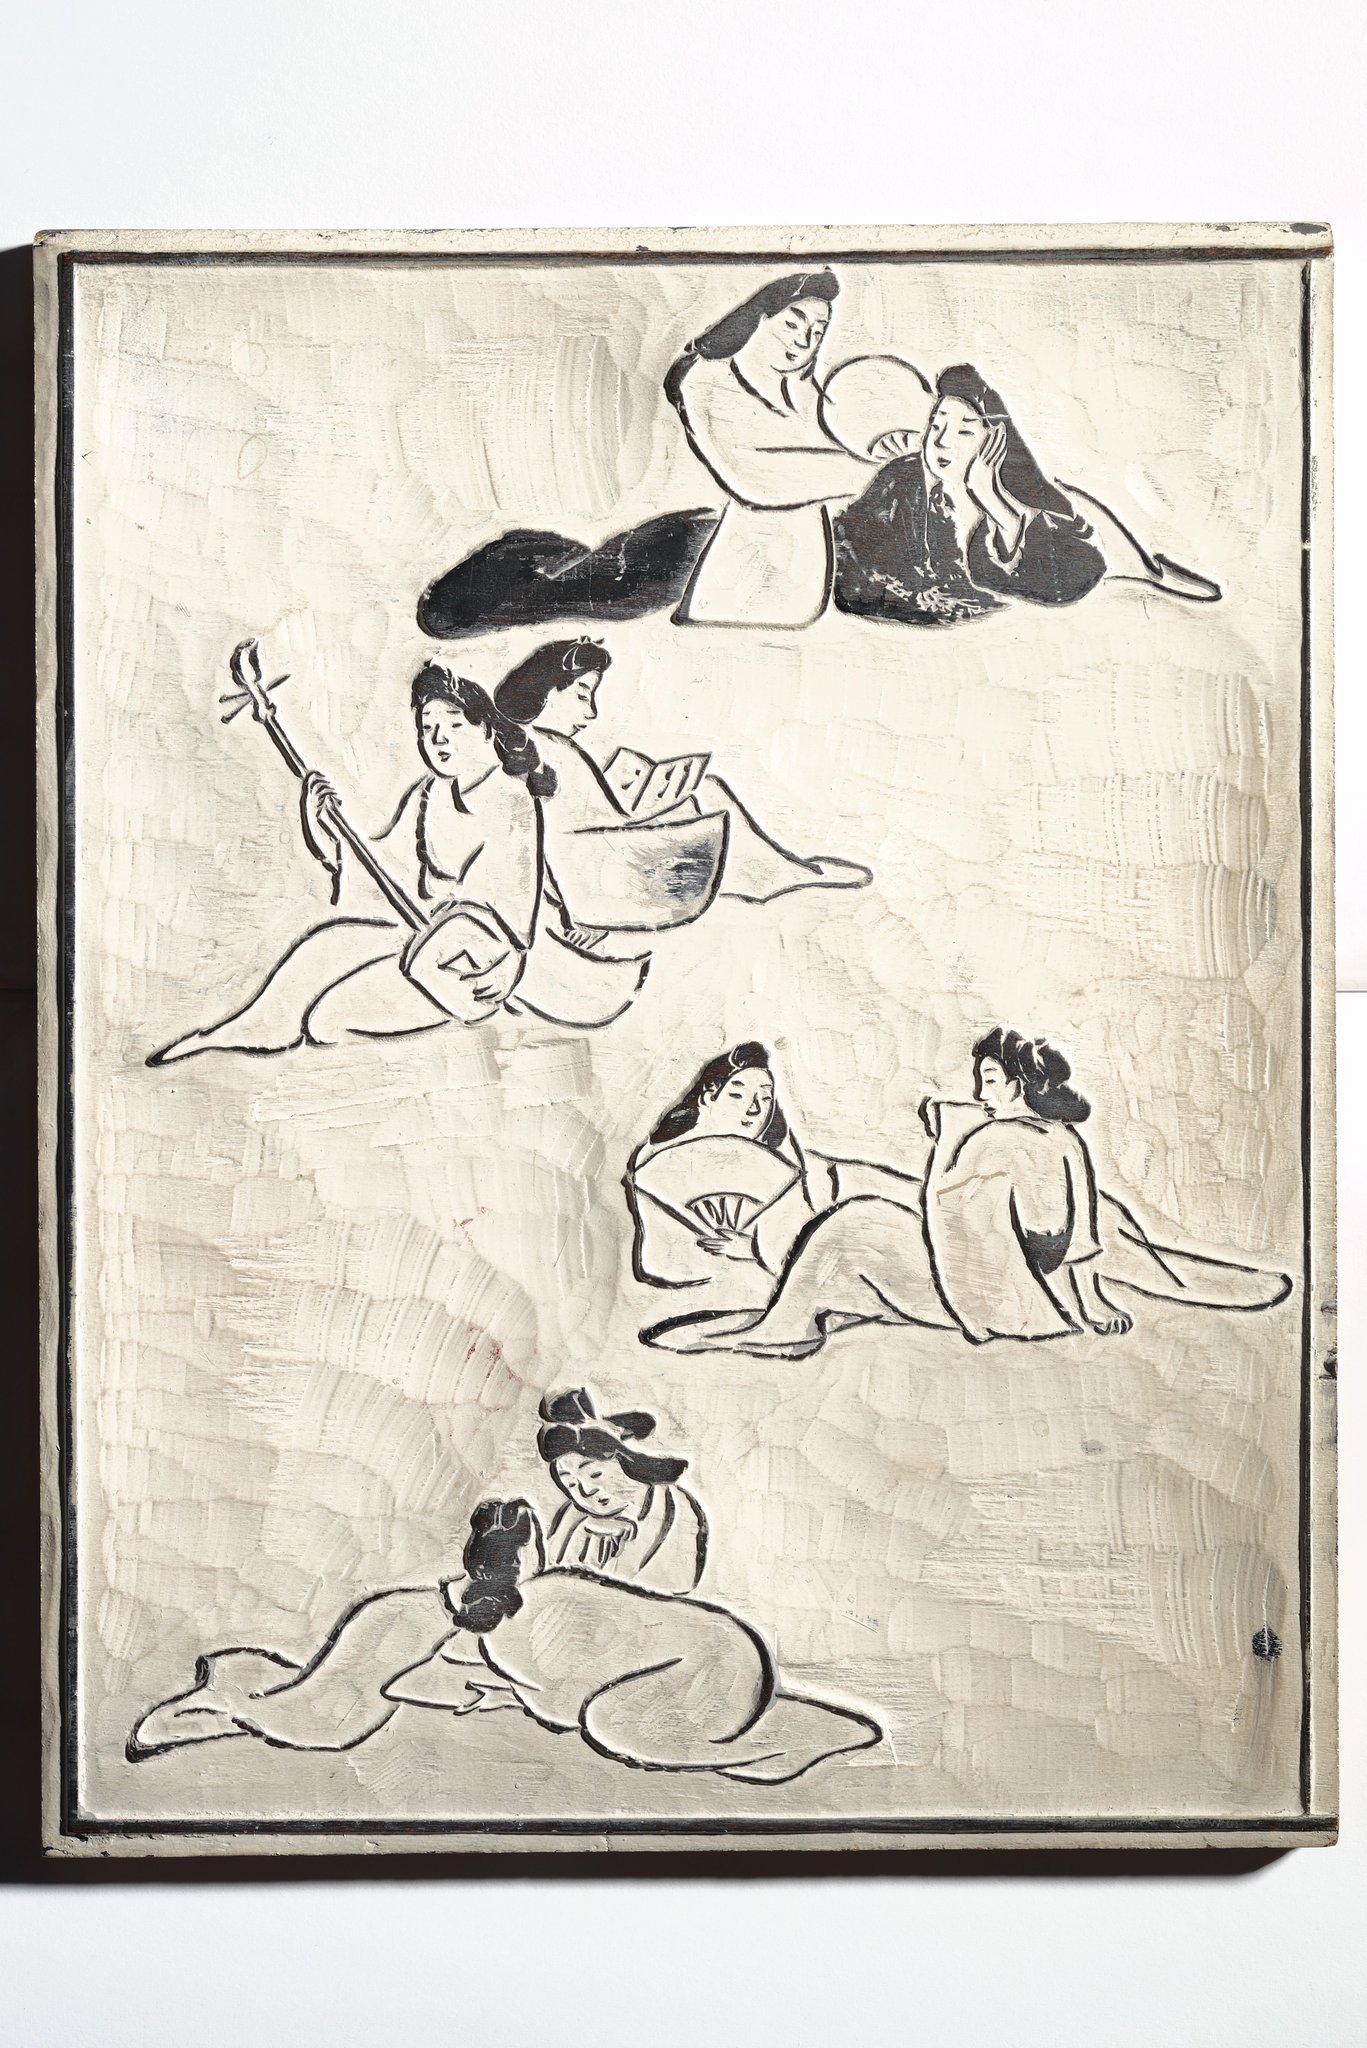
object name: woodblock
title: Facsimile of Woodblock for an illustrated Page of a Book by Keisai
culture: japanese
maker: kuwagata keisai 鍬形蕙斎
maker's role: artist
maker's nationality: japanese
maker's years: 1764-1824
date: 1801-1900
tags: musical instruments,fans,women